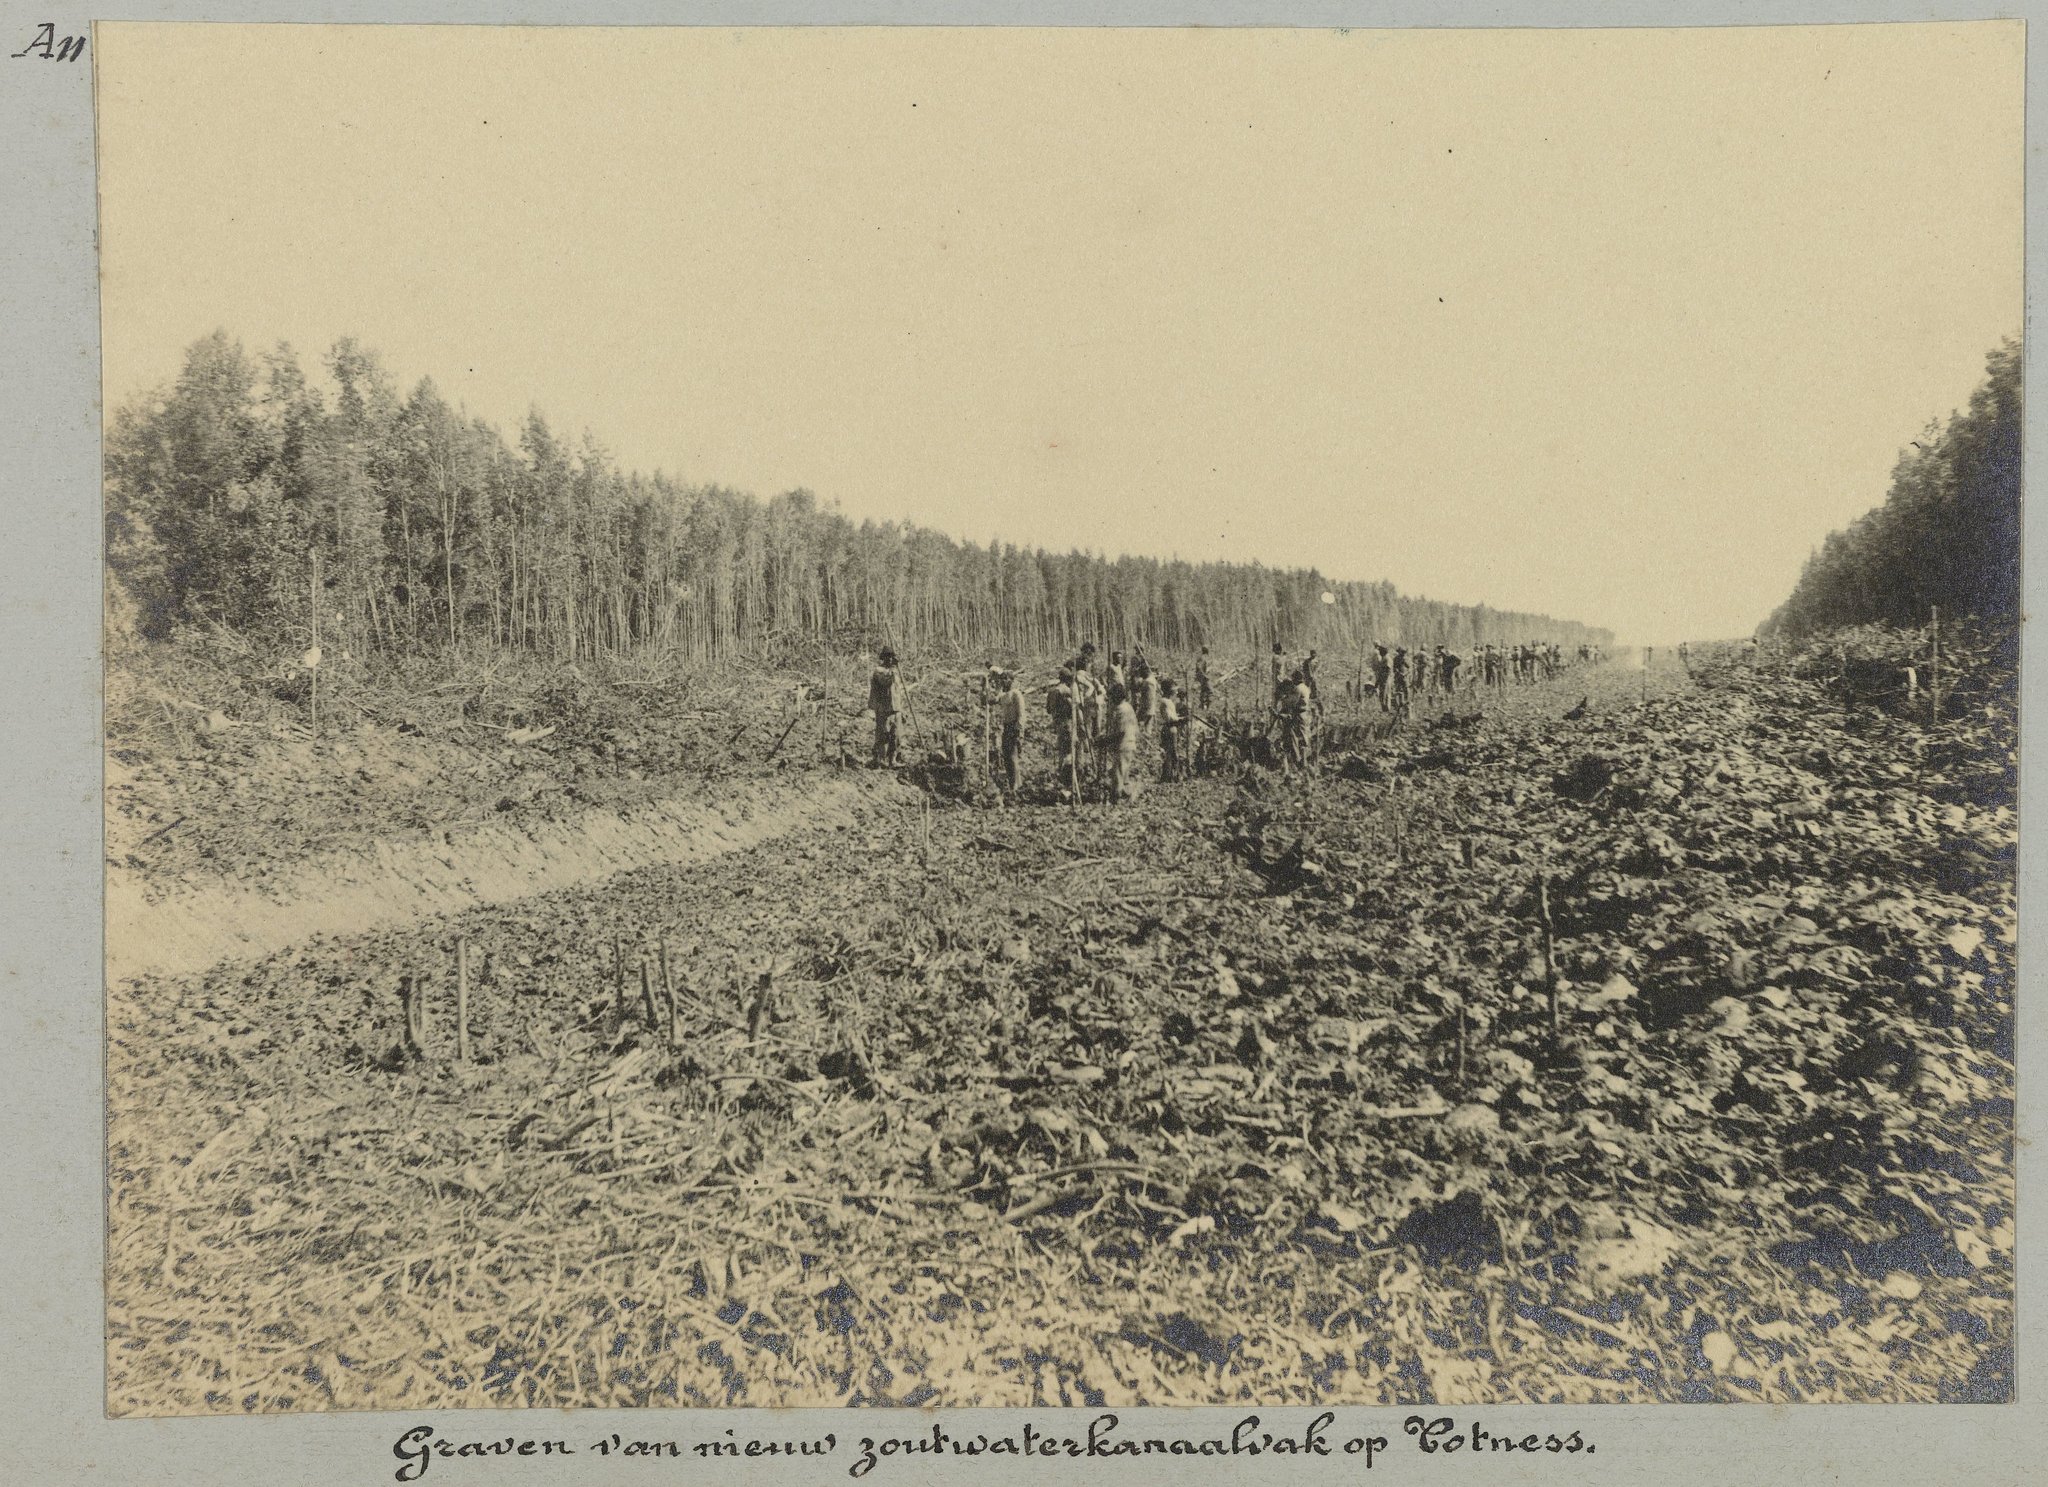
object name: photograph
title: Graven van nieuw zoutwaterkanaalvak op Totness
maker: hendrik doijer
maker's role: engineer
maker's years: 1863-1925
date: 1903-1910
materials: photographic support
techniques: gelatin silver print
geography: suriname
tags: suriname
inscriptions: inscription: ‘A11 / Graven van nieuw zoutwaterkanaalvak op Totness.’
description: Een grote groep arbeiders ingezet bij de graafwerkzaamheden voor een nieuw stuk van het zoutwaterkanaal van Totness. Onderdeel van het fotoalbum Souvenir de Voyage (deel 1), over het leven van de familie Doijer in en rond de plantage Ma Retraite in Suriname in de jaren 1903-1910.